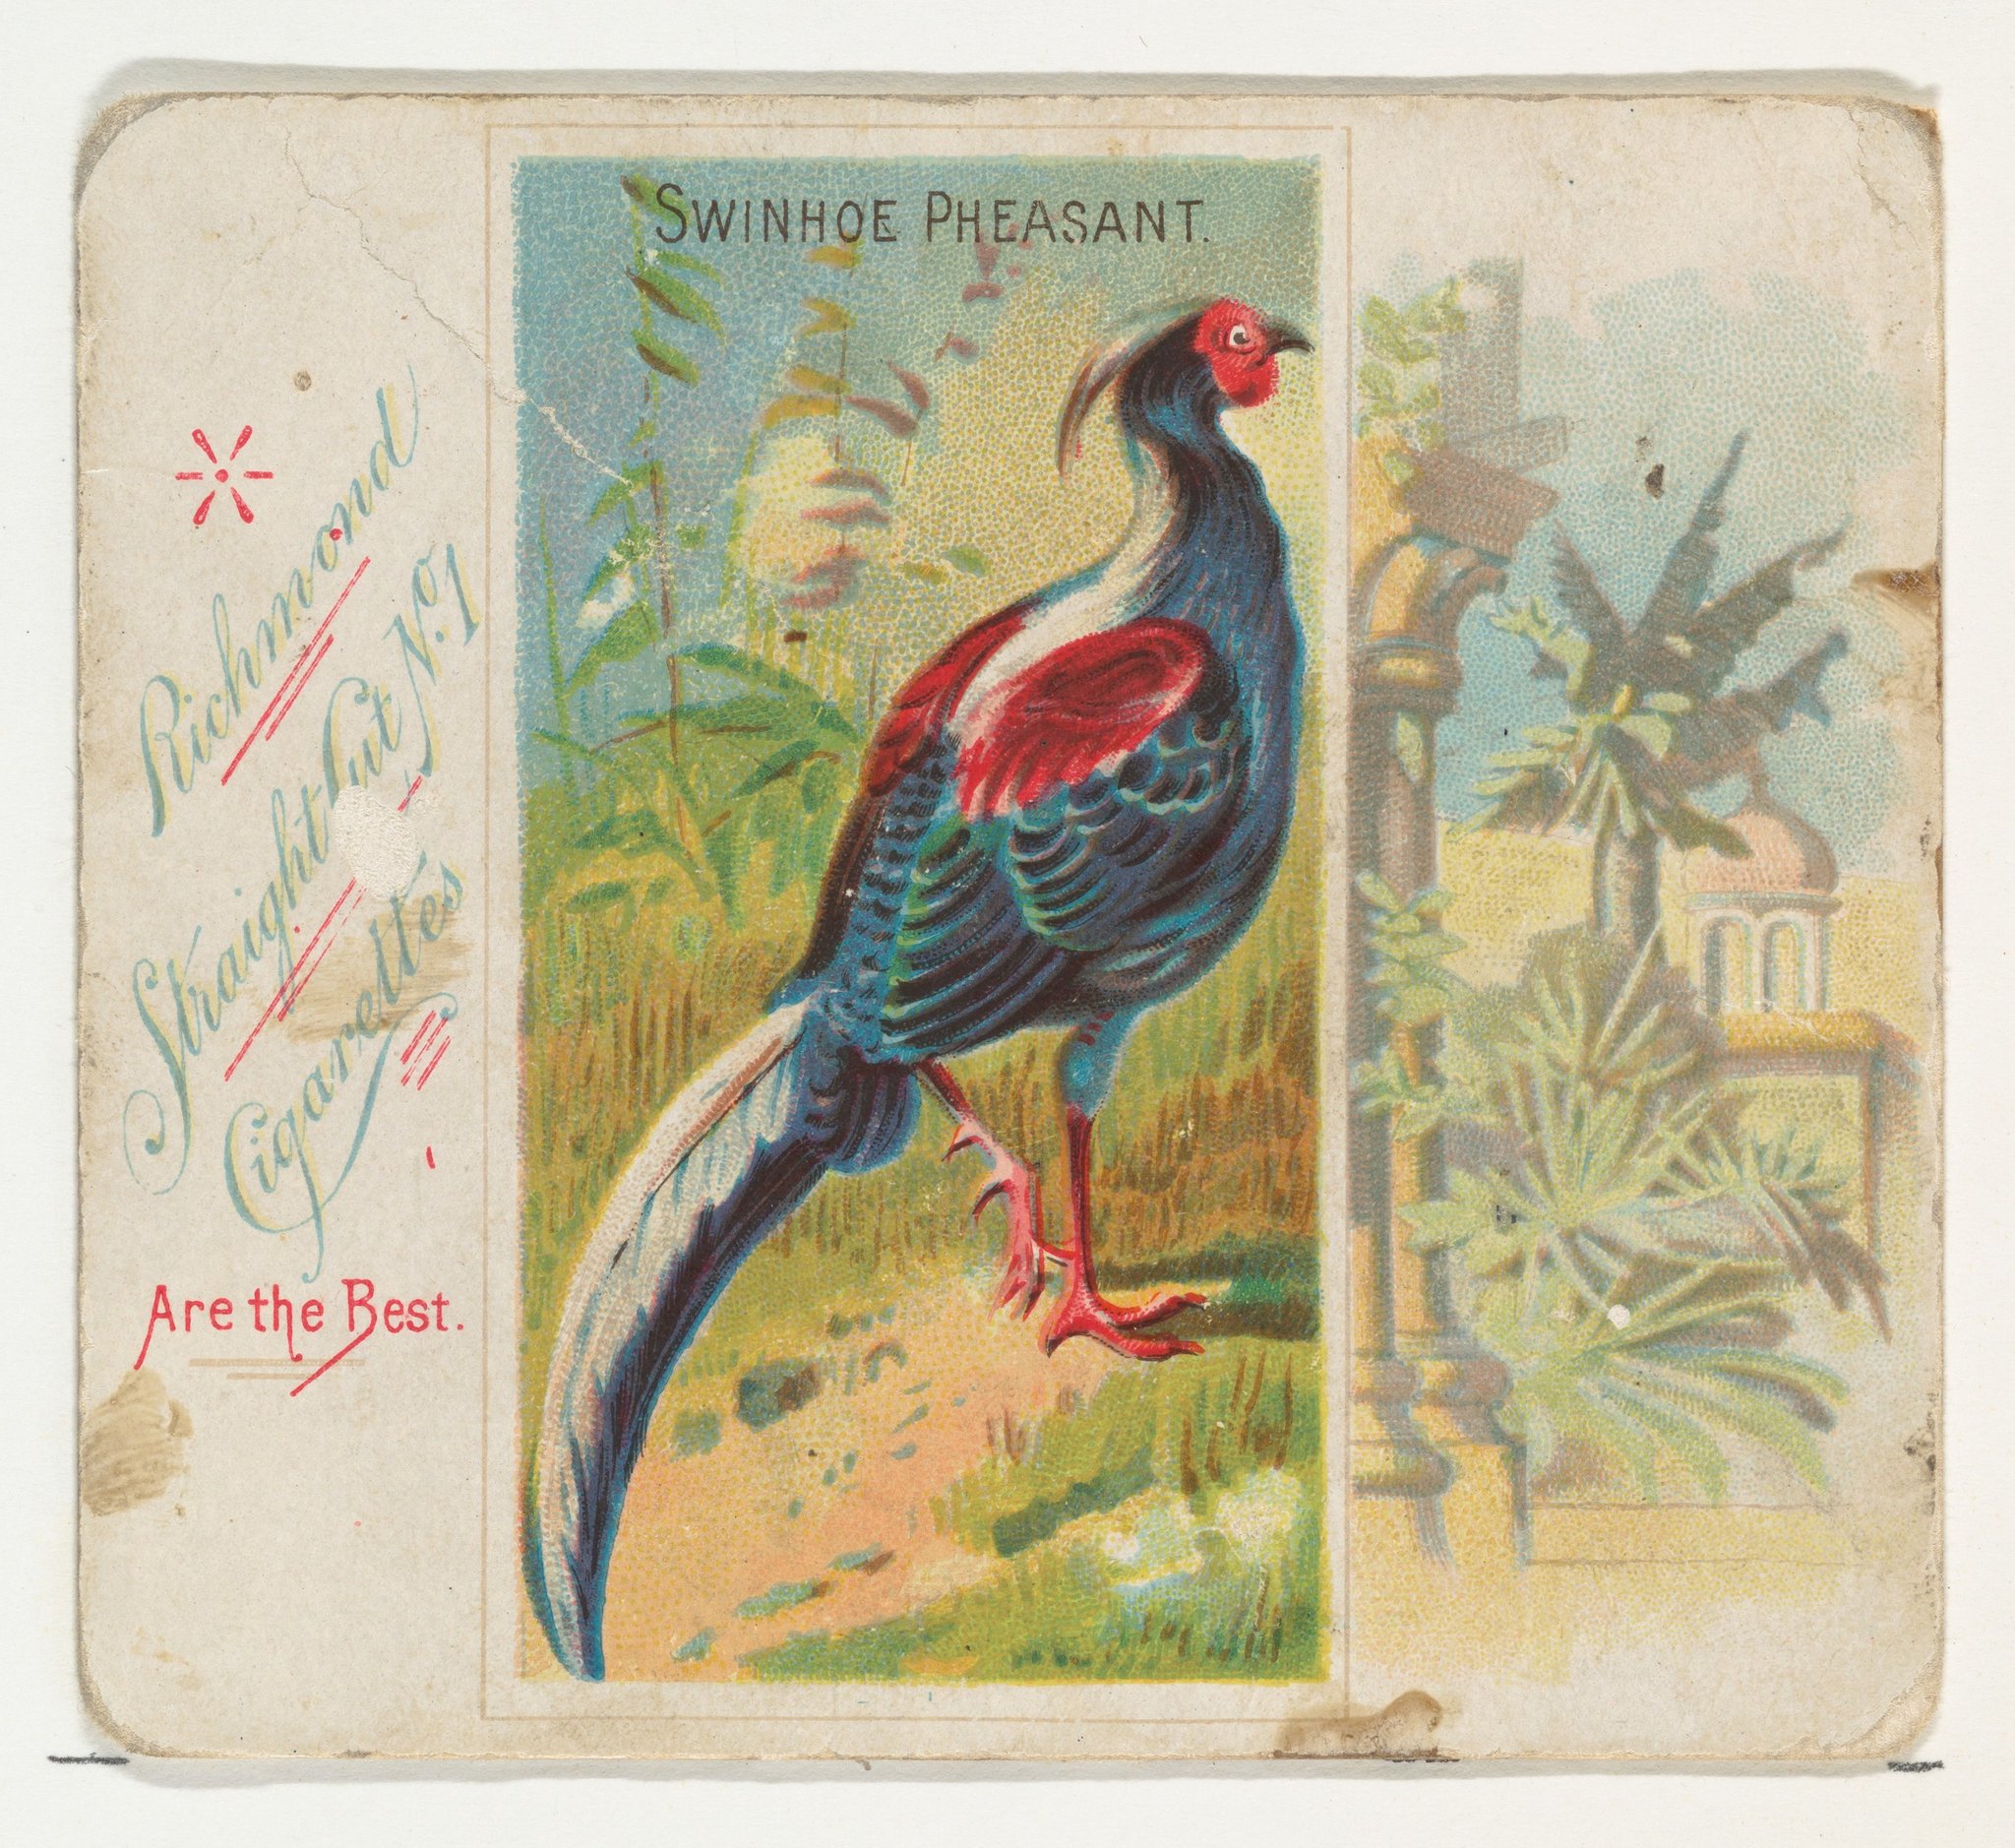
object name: print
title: Swinhoe Pheasant, from Birds of the Tropics series (N38) for Allen & Ginter Cigarettes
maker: allen & ginter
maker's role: publisher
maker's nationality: american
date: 1889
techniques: color lithograph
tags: pheasants